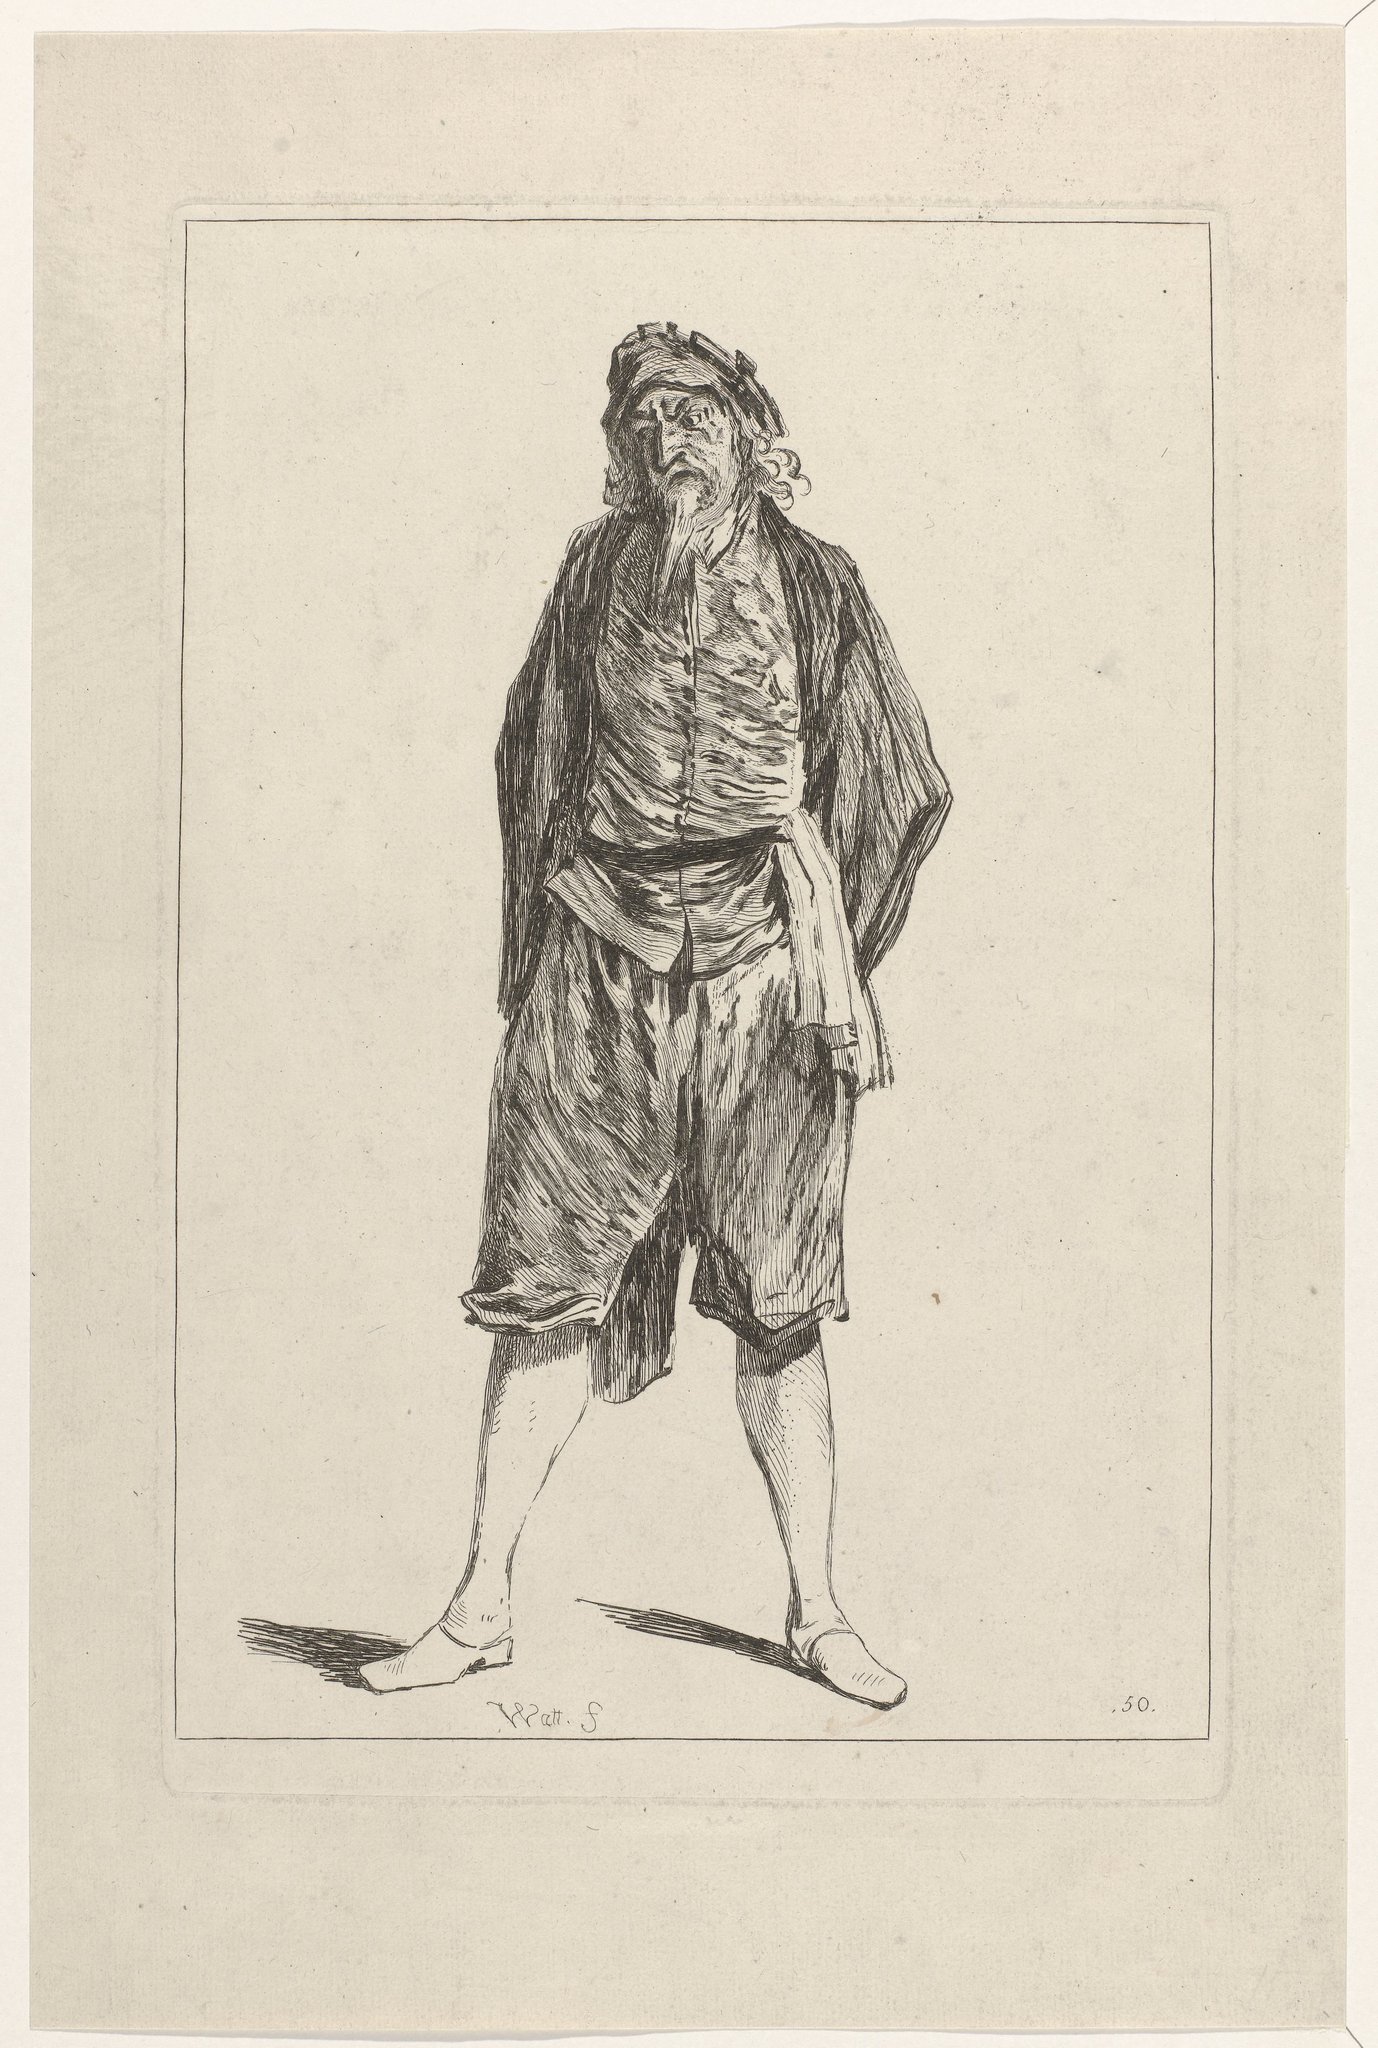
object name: costume print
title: Figures de differents caractères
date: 1700-1725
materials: paper